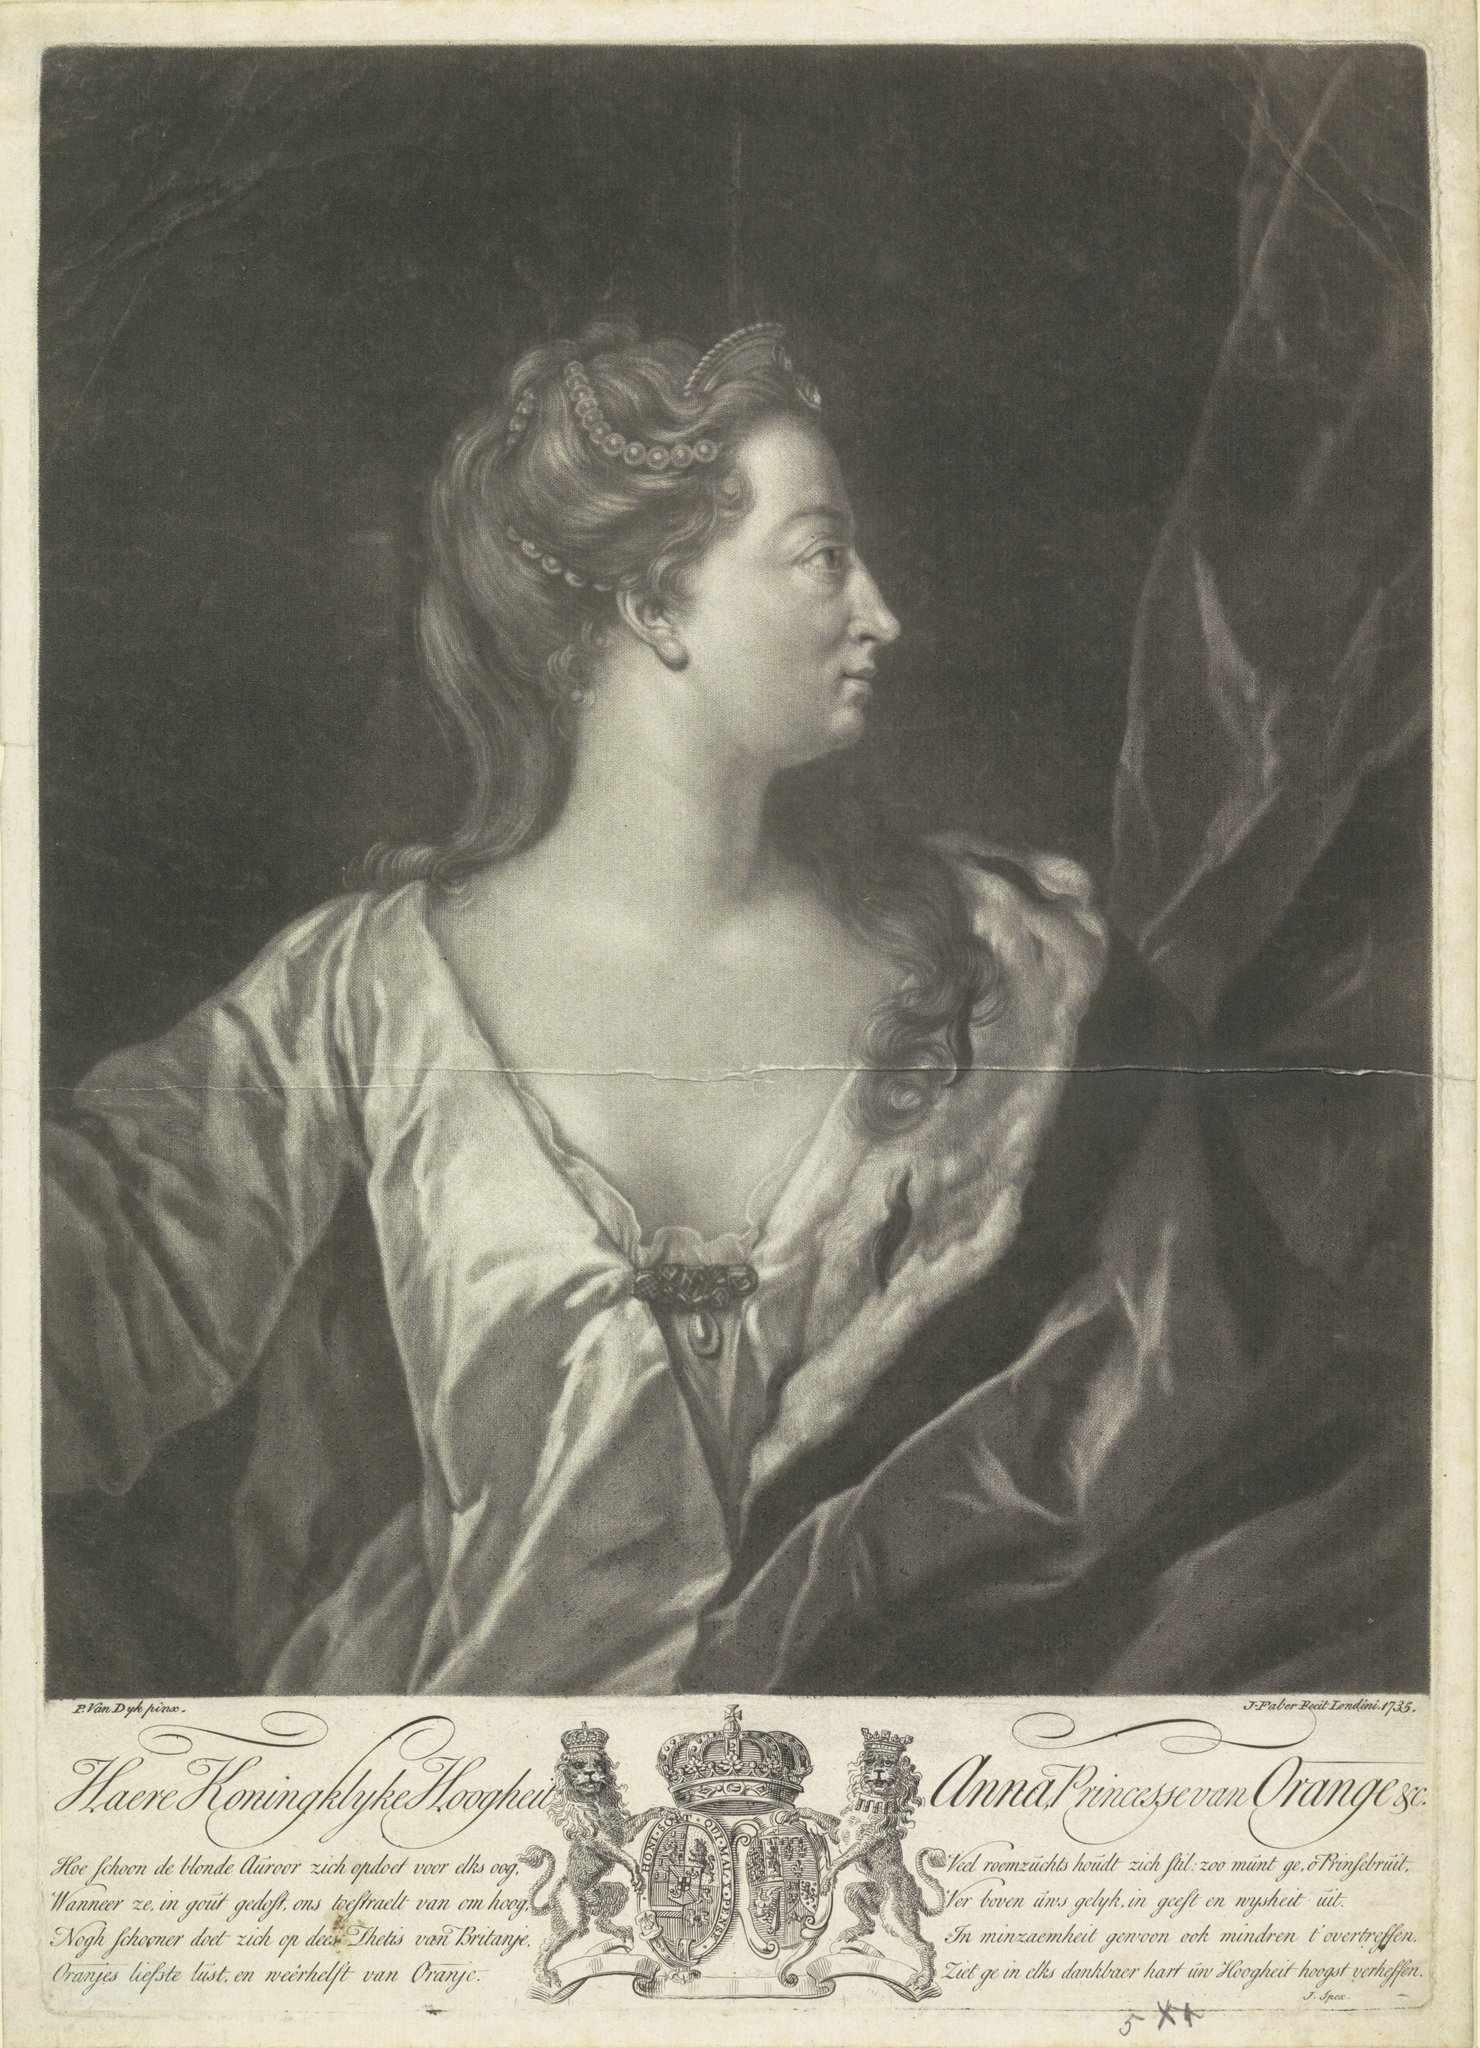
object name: print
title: Portret van Anna van Hannover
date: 1735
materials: paper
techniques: mezzotint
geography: london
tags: willem iv (prins van oranje-nassau), the hague, anna van hannover, knighthood order (garter) - insignia of a knighthood order, e.g.: badge, chain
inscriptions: date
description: Portret van Anna. Midden onder haar wapen en het wapen van Willem IV, gedecoreerd met de Kousenband en het devies van de Orde van de Kousenband, met een kroon en twee leeuwen. In de ondermarge haar naam, haar titels en twee kolommen met elk vier regels Nederlandse tekst.